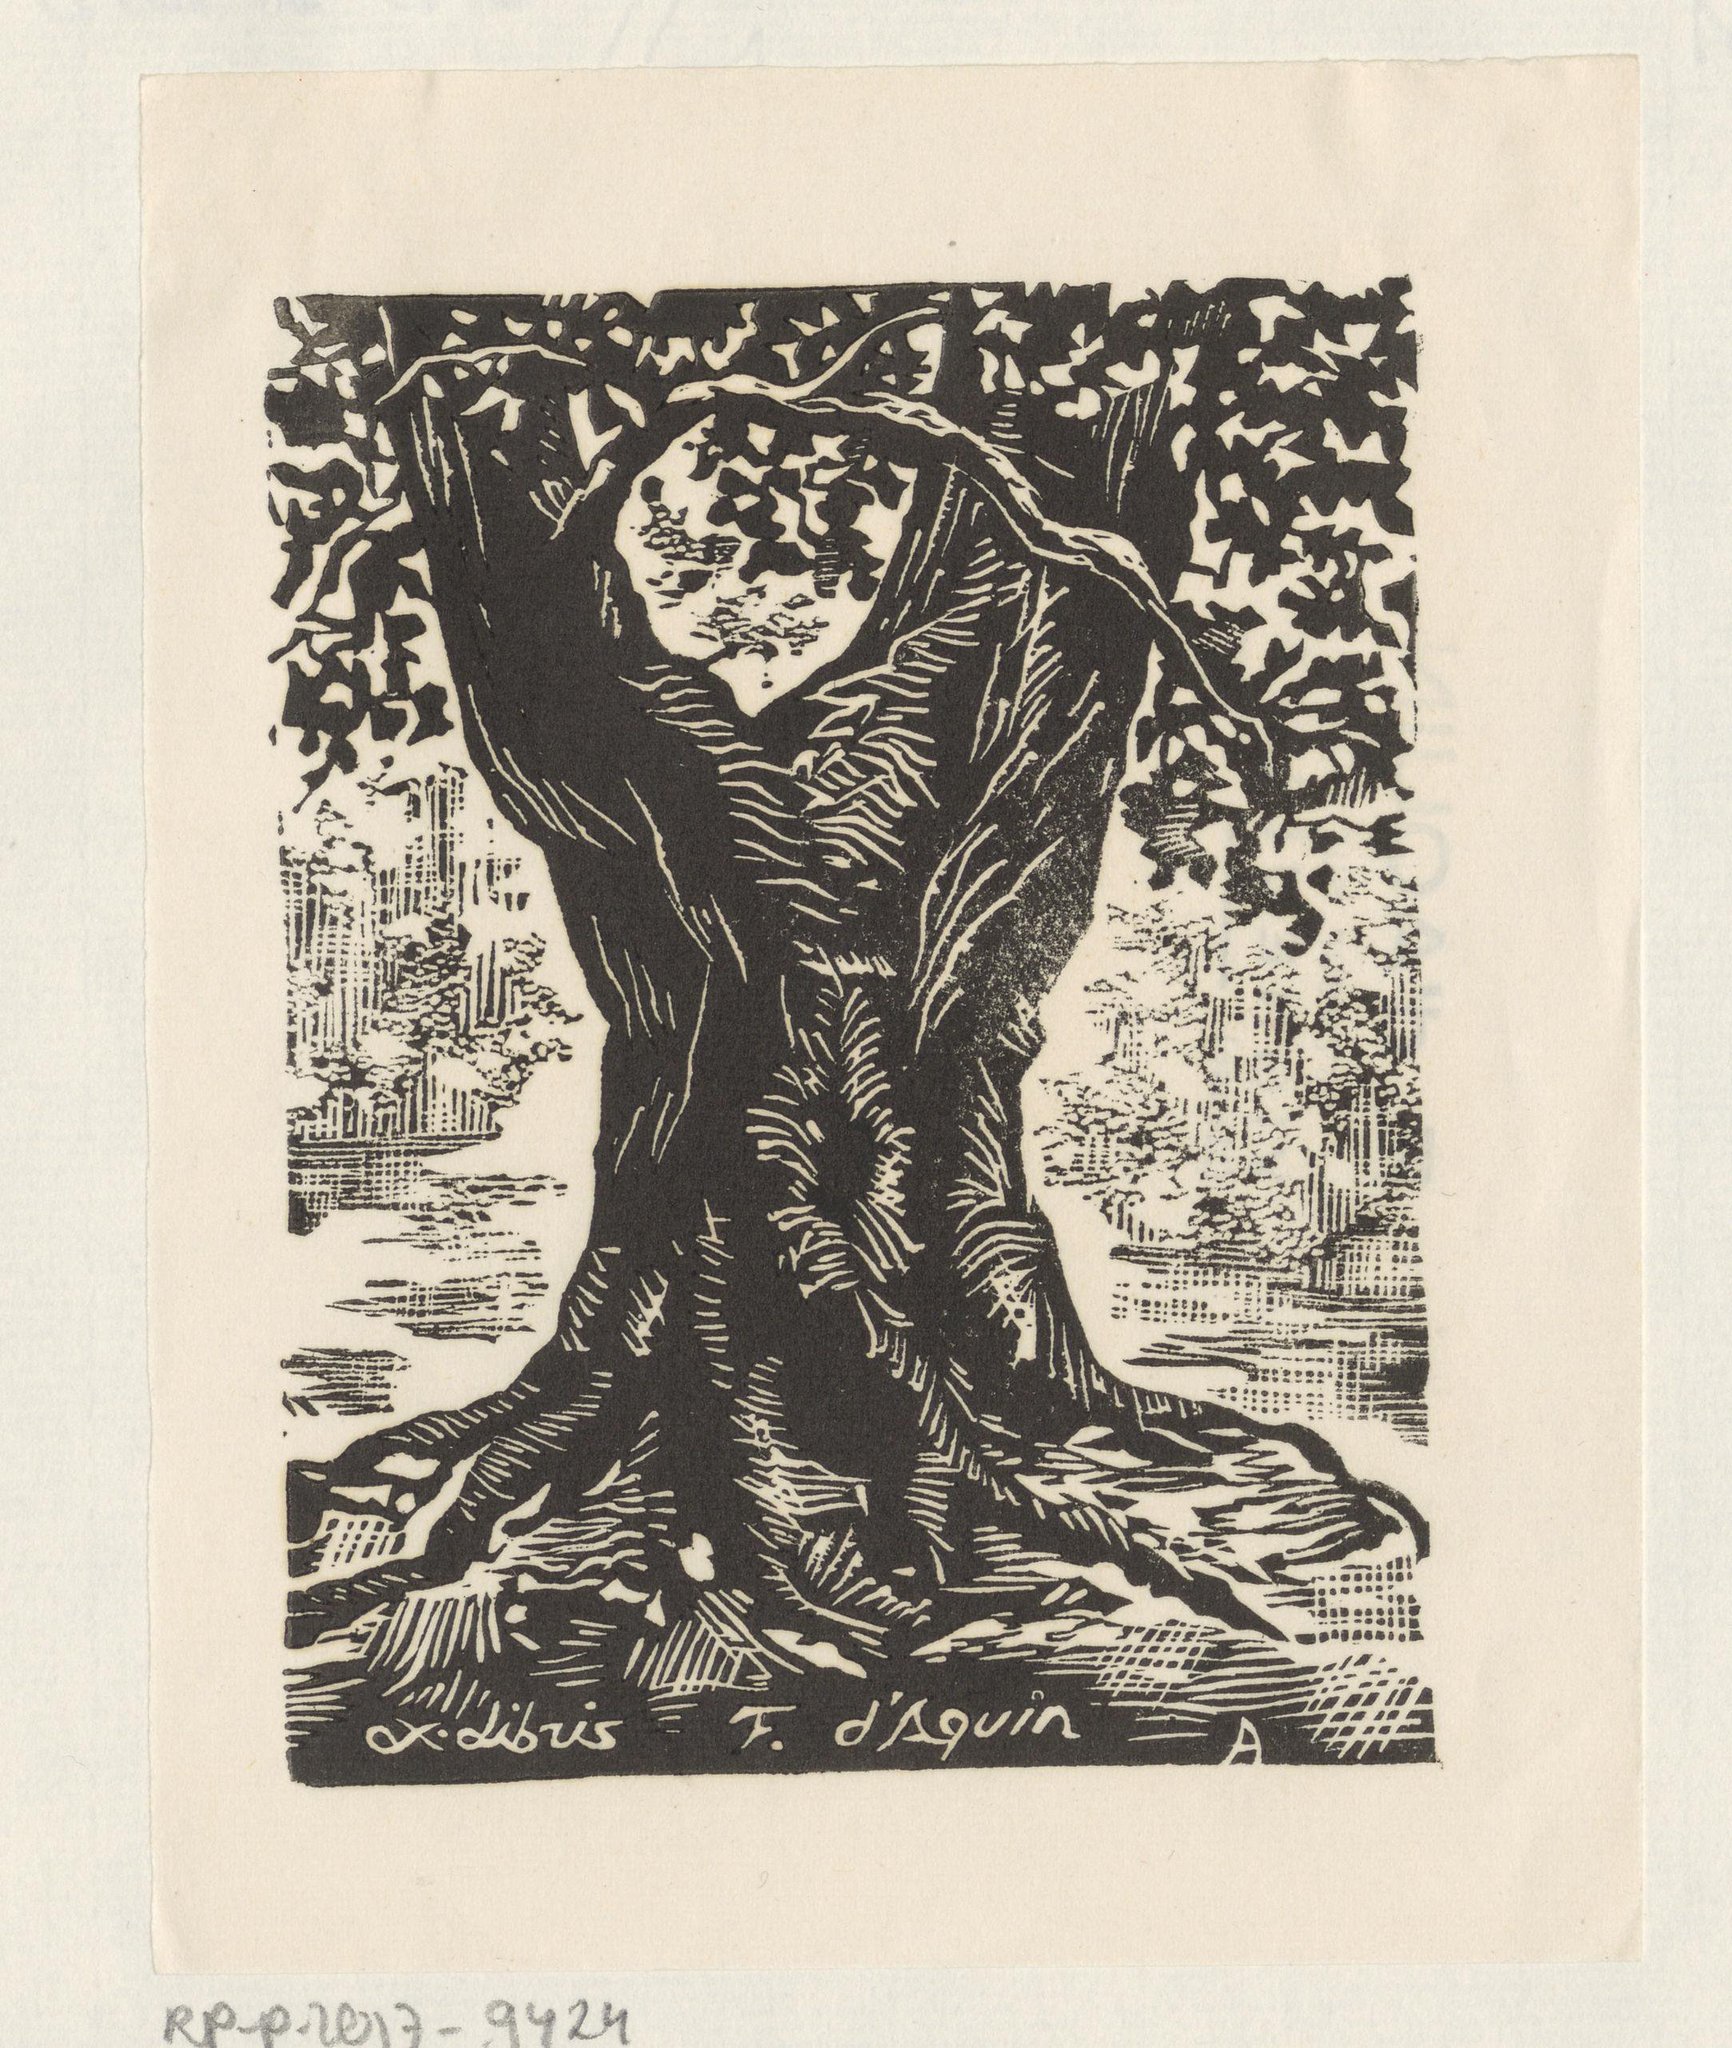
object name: bookplate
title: Ex libris van François d'Aquin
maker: françois d aquin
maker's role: print maker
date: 1900-1999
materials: paper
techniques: woodcut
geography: france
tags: print maker, françois d' aquin, trees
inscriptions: workshop stamp: ‘F. d'Aquin/ Graveur sur bois/ Vigneulles/ (Meuse) France’